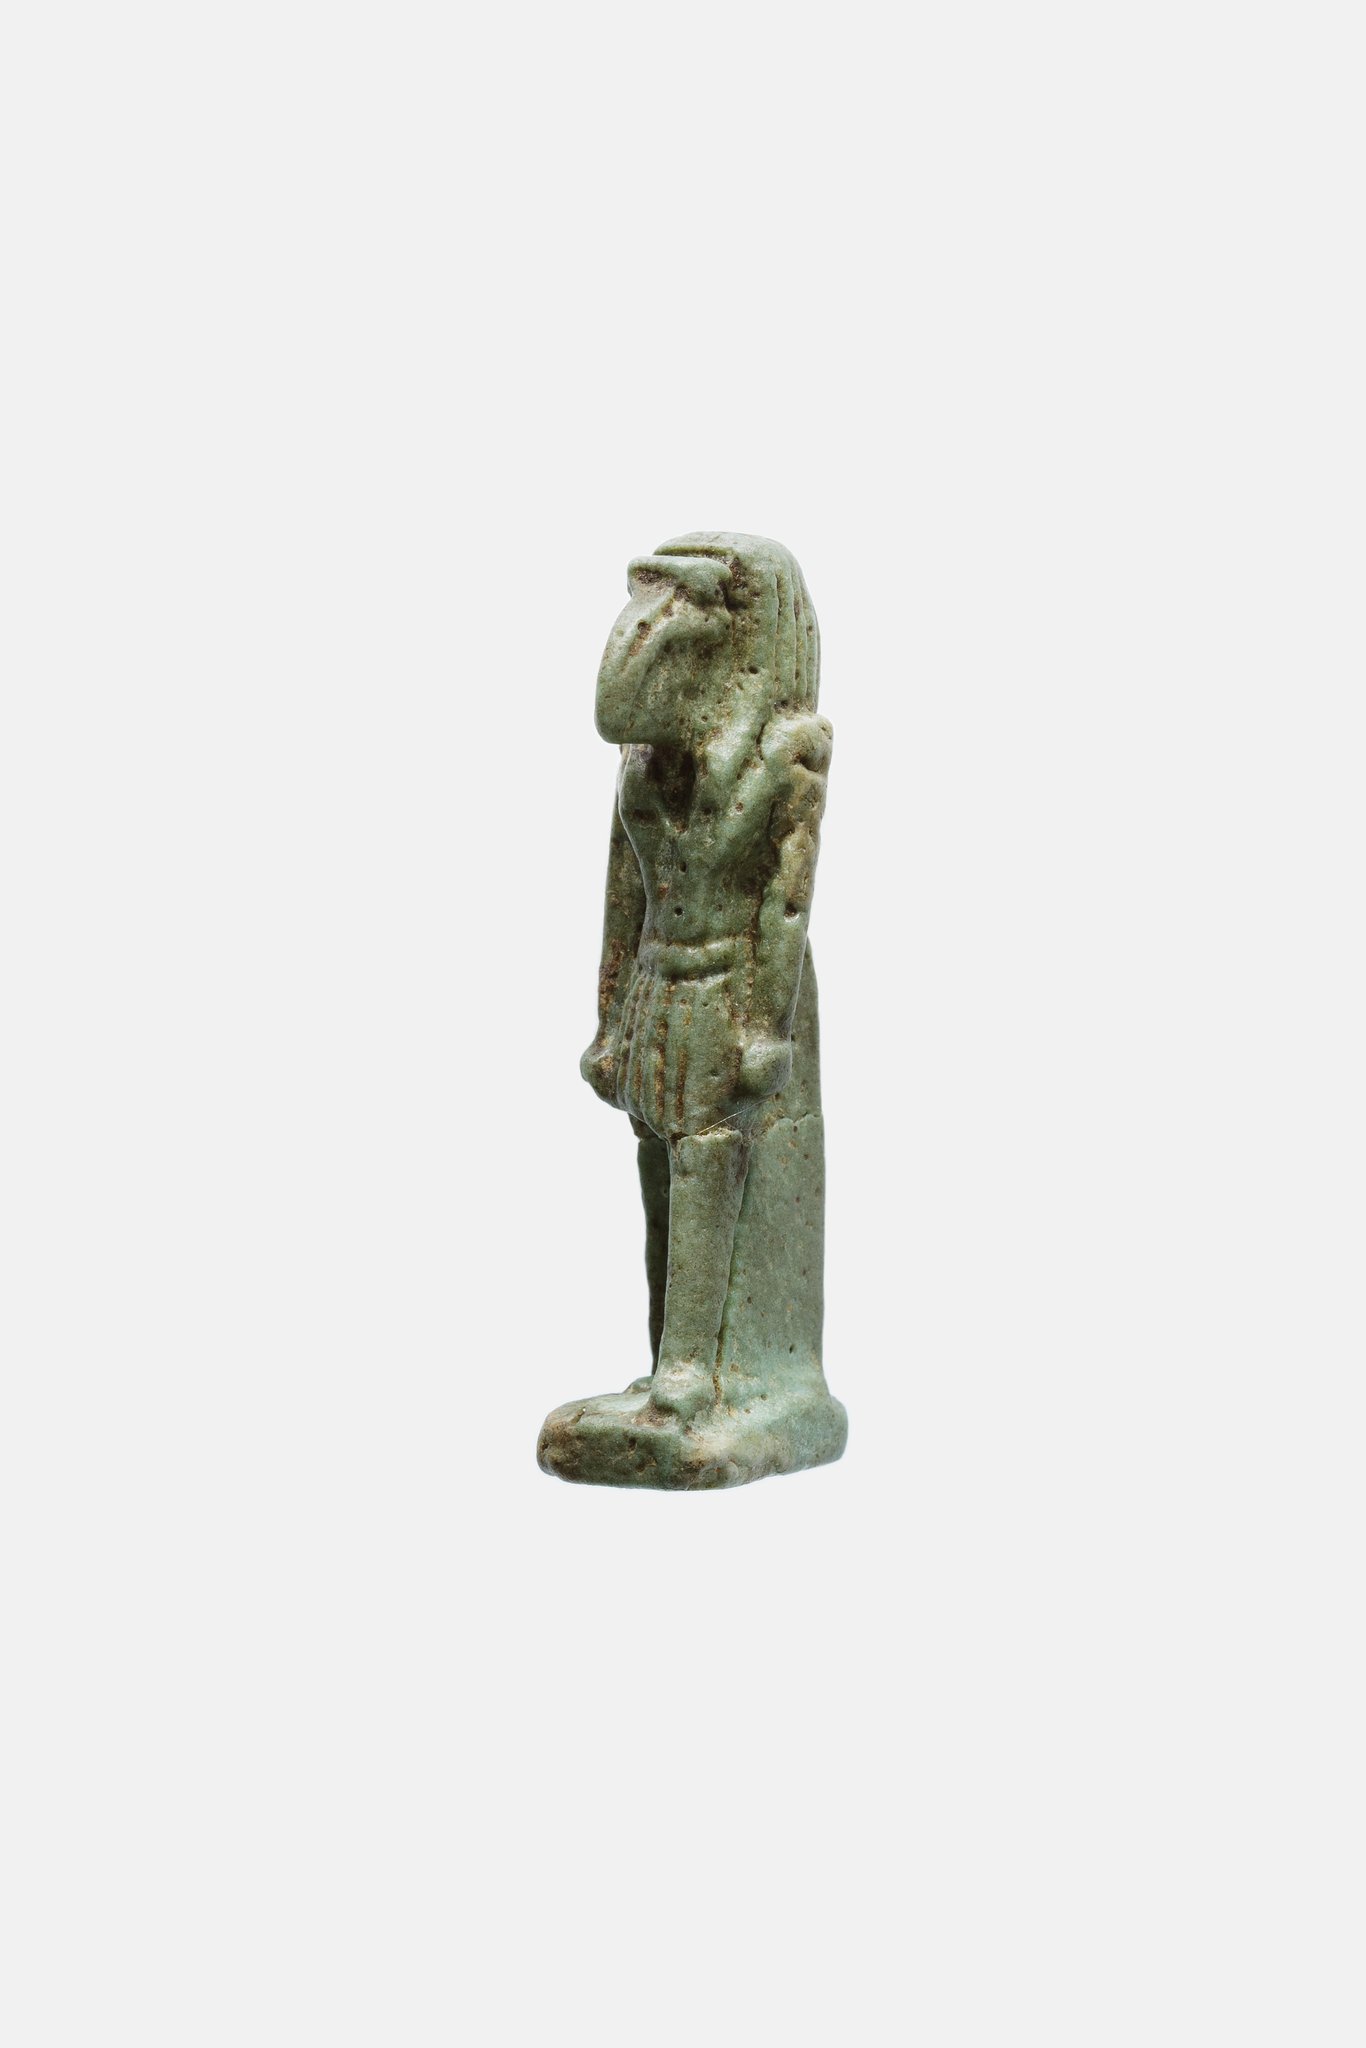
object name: amulet, thoth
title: Amulet of Thoth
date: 522-343 BCE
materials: faience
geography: egypt